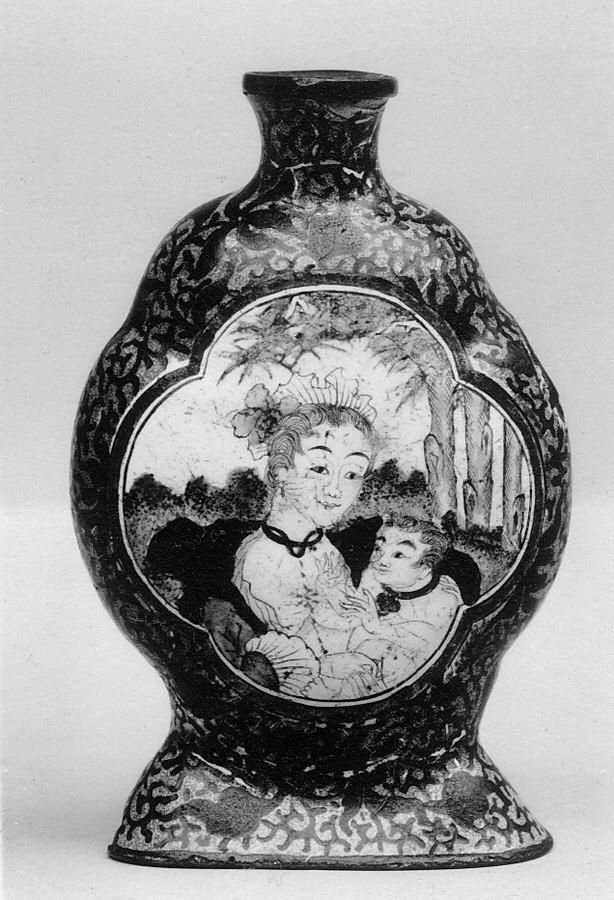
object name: snuff bottle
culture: chinese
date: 1736-1795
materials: enamel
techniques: painting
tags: boys,women